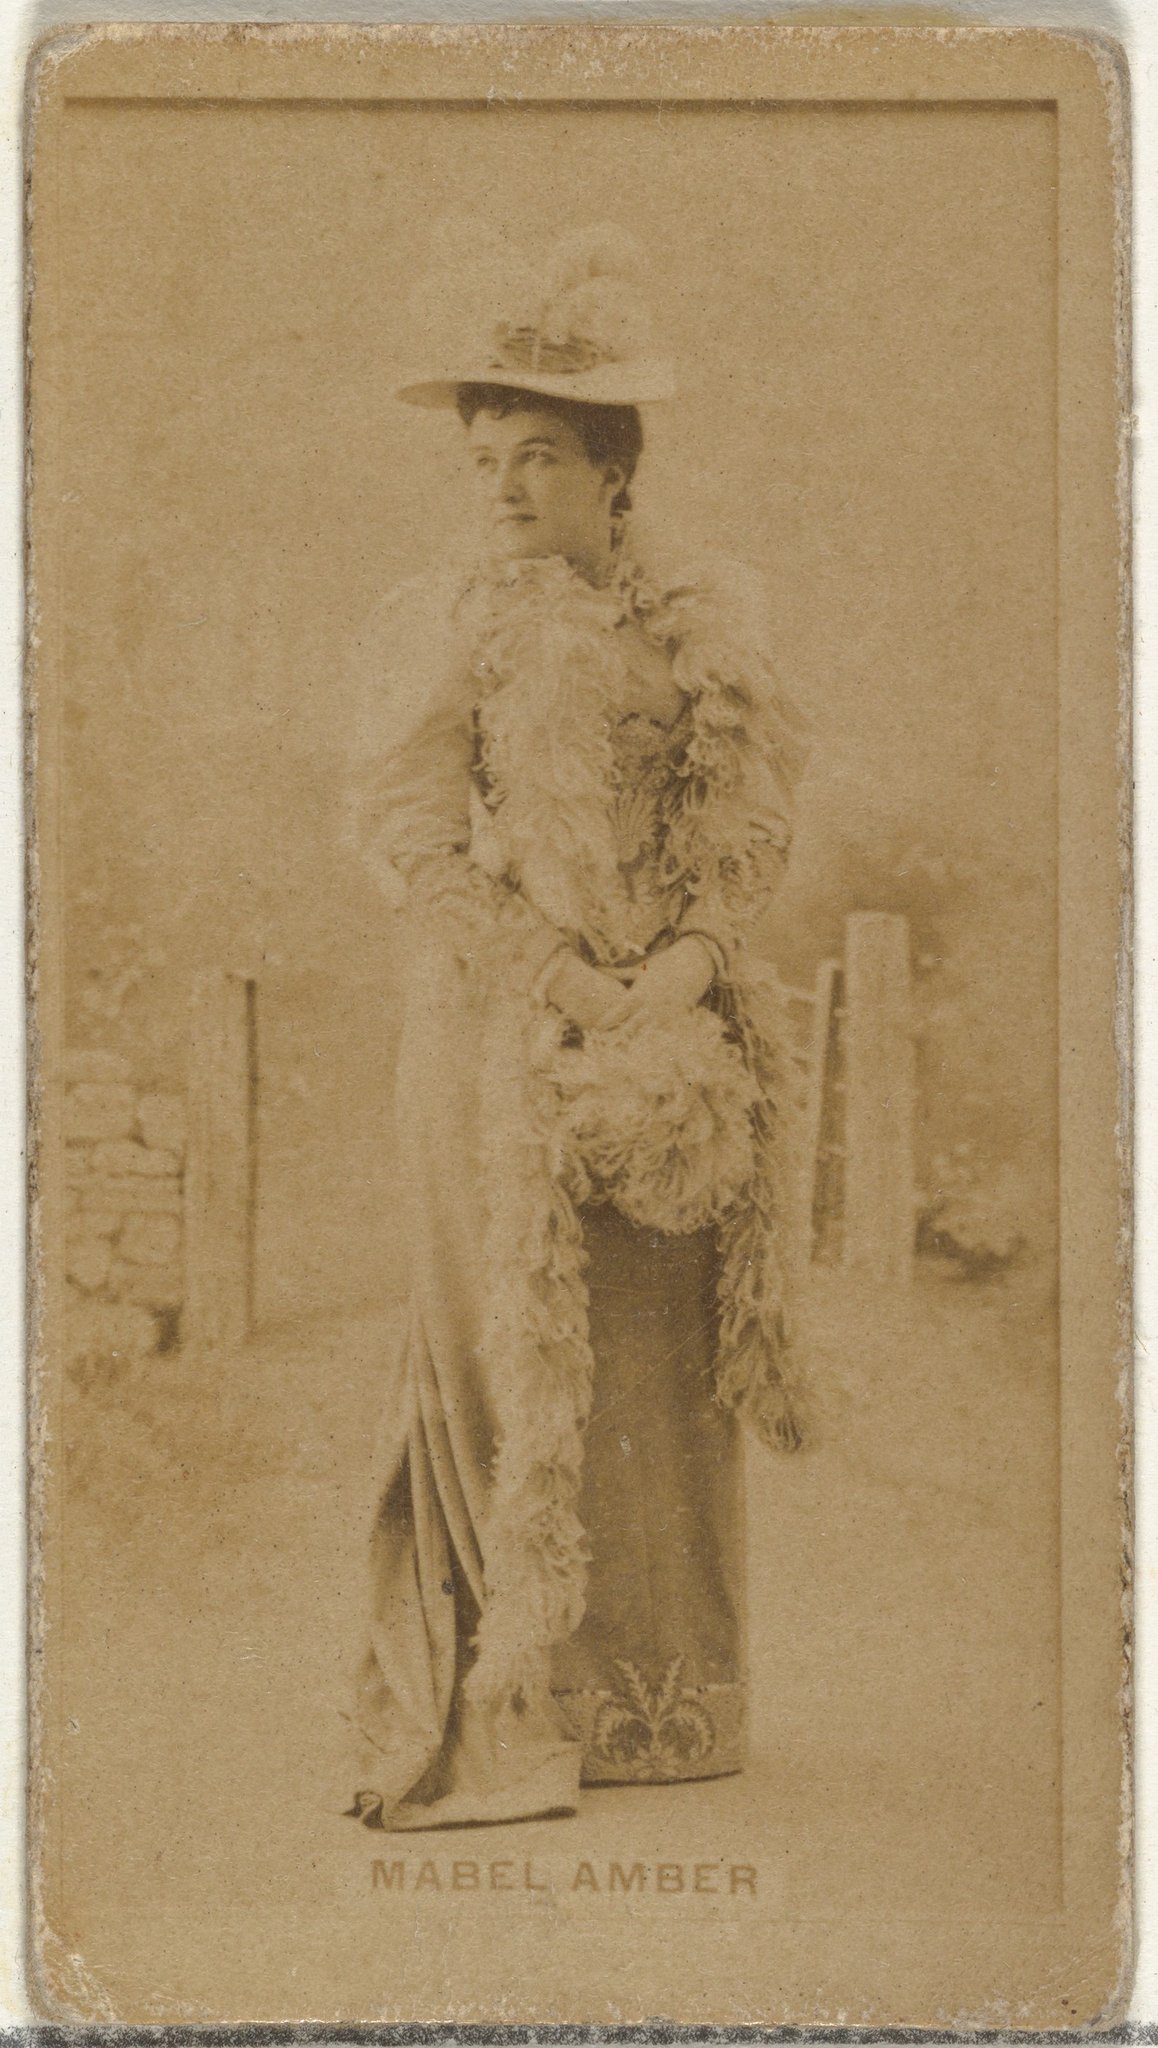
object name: photograph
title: Mabel Amber, from the Actors and Actresses series (N145-8) issued by Duke Sons & Co. to promote Duke Cigarettes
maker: w. duke, sons & co.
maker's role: publisher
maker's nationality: american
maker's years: 1870-1920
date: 1891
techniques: albumen silver print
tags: portraits,women,actresses